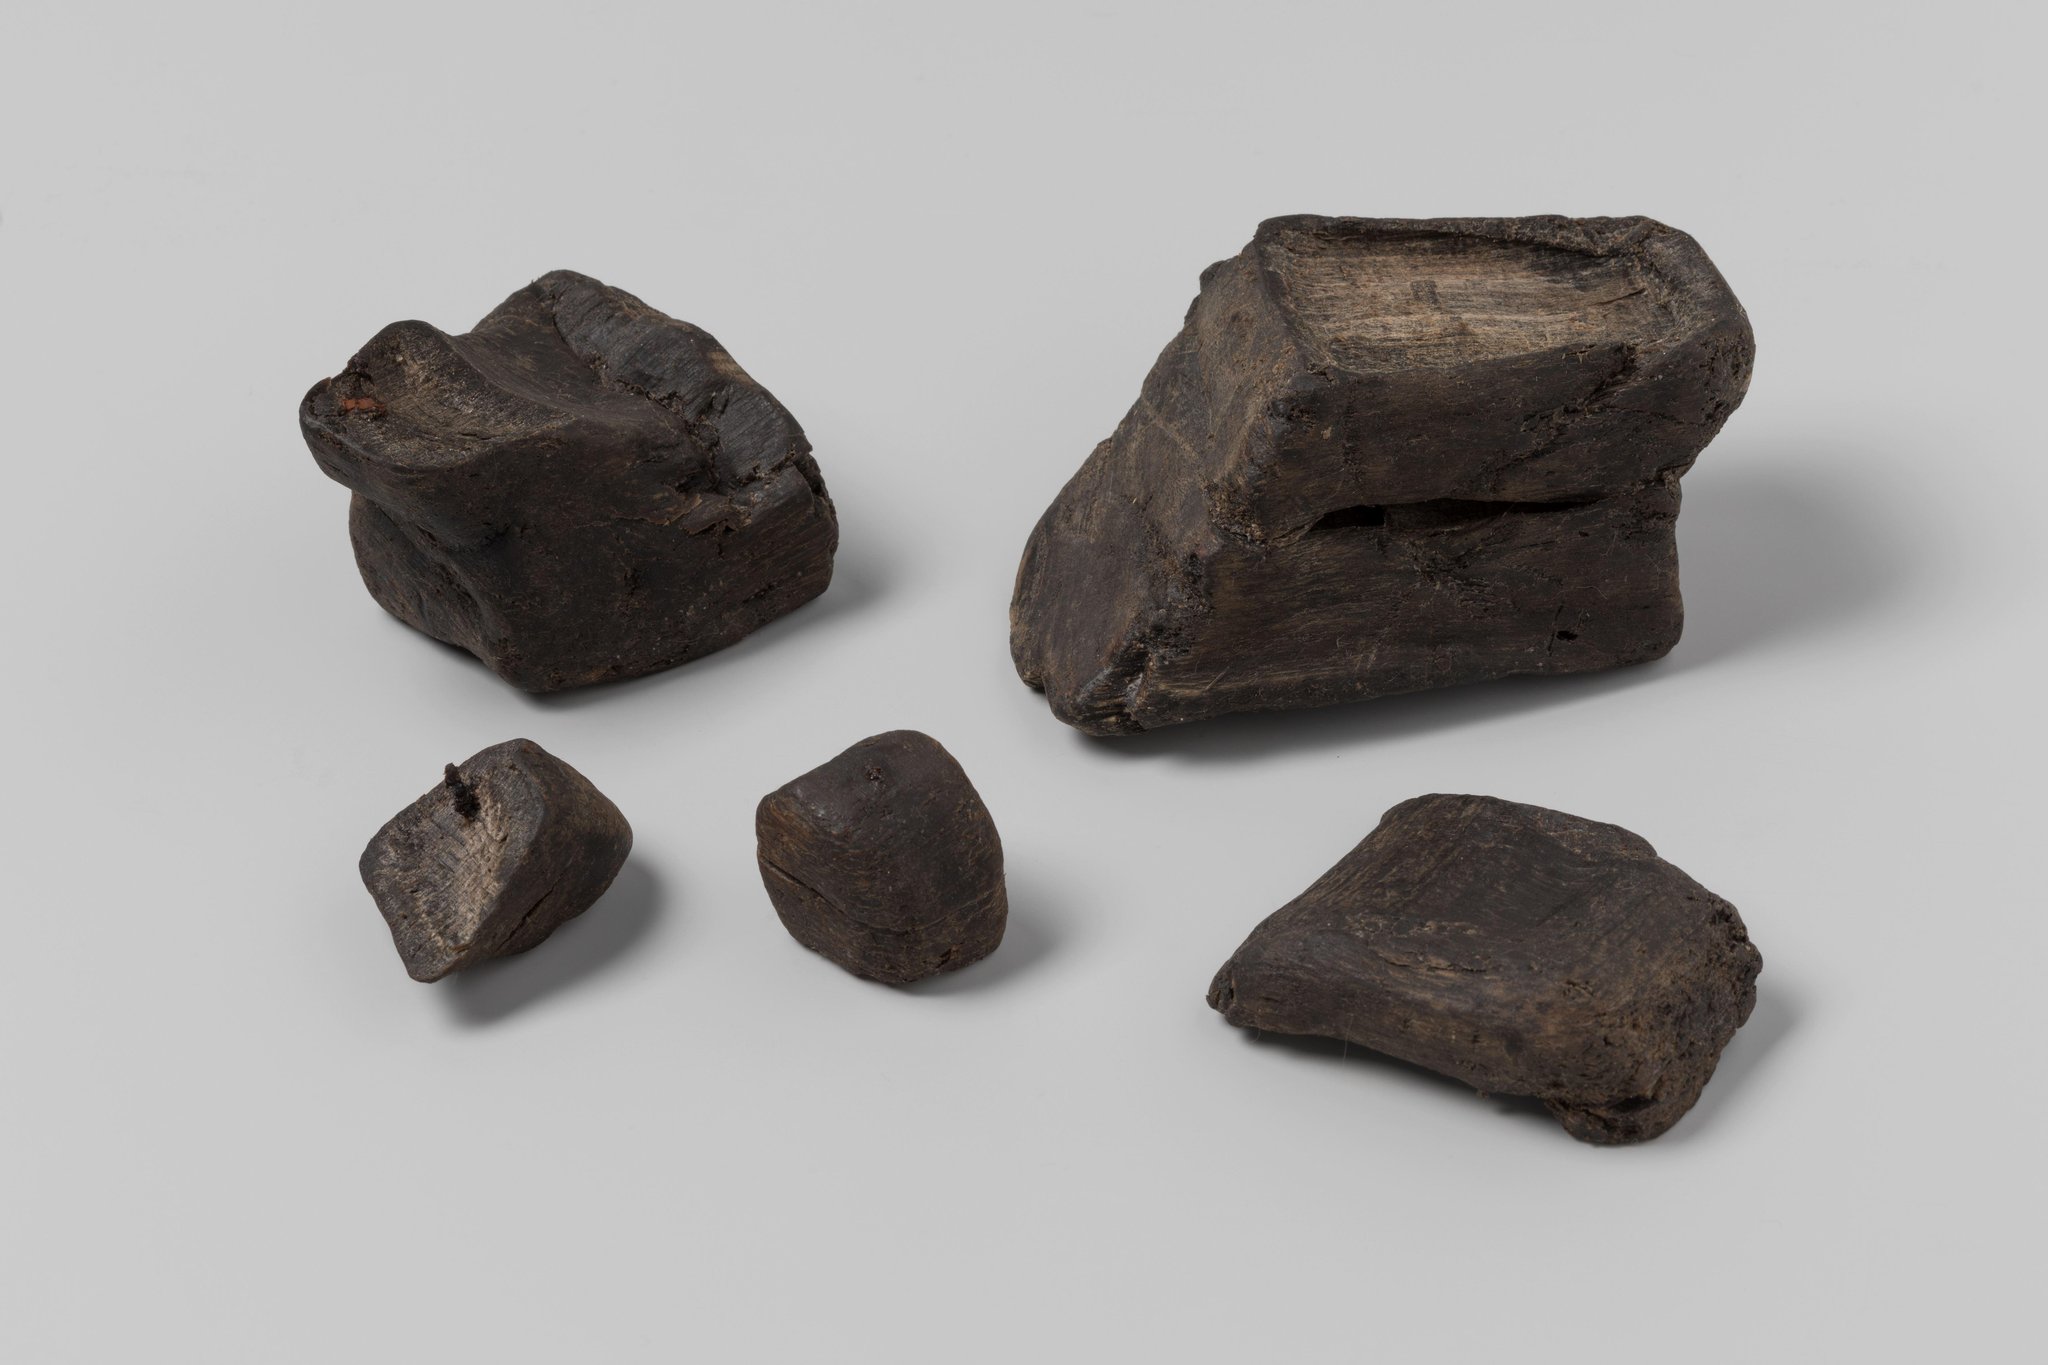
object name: plane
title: Schaaf uit het wrak van de Oost-Indiëvaarder Hollandia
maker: Anonymous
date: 1700-1743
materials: iron, wood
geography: netherlands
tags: verenigde oostindische compagnie, hollandia (schip), annet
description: Tools and instruments, woodworking, plane; fragm of smoothing plane, broken: curved front grip, back of the stock rounded.